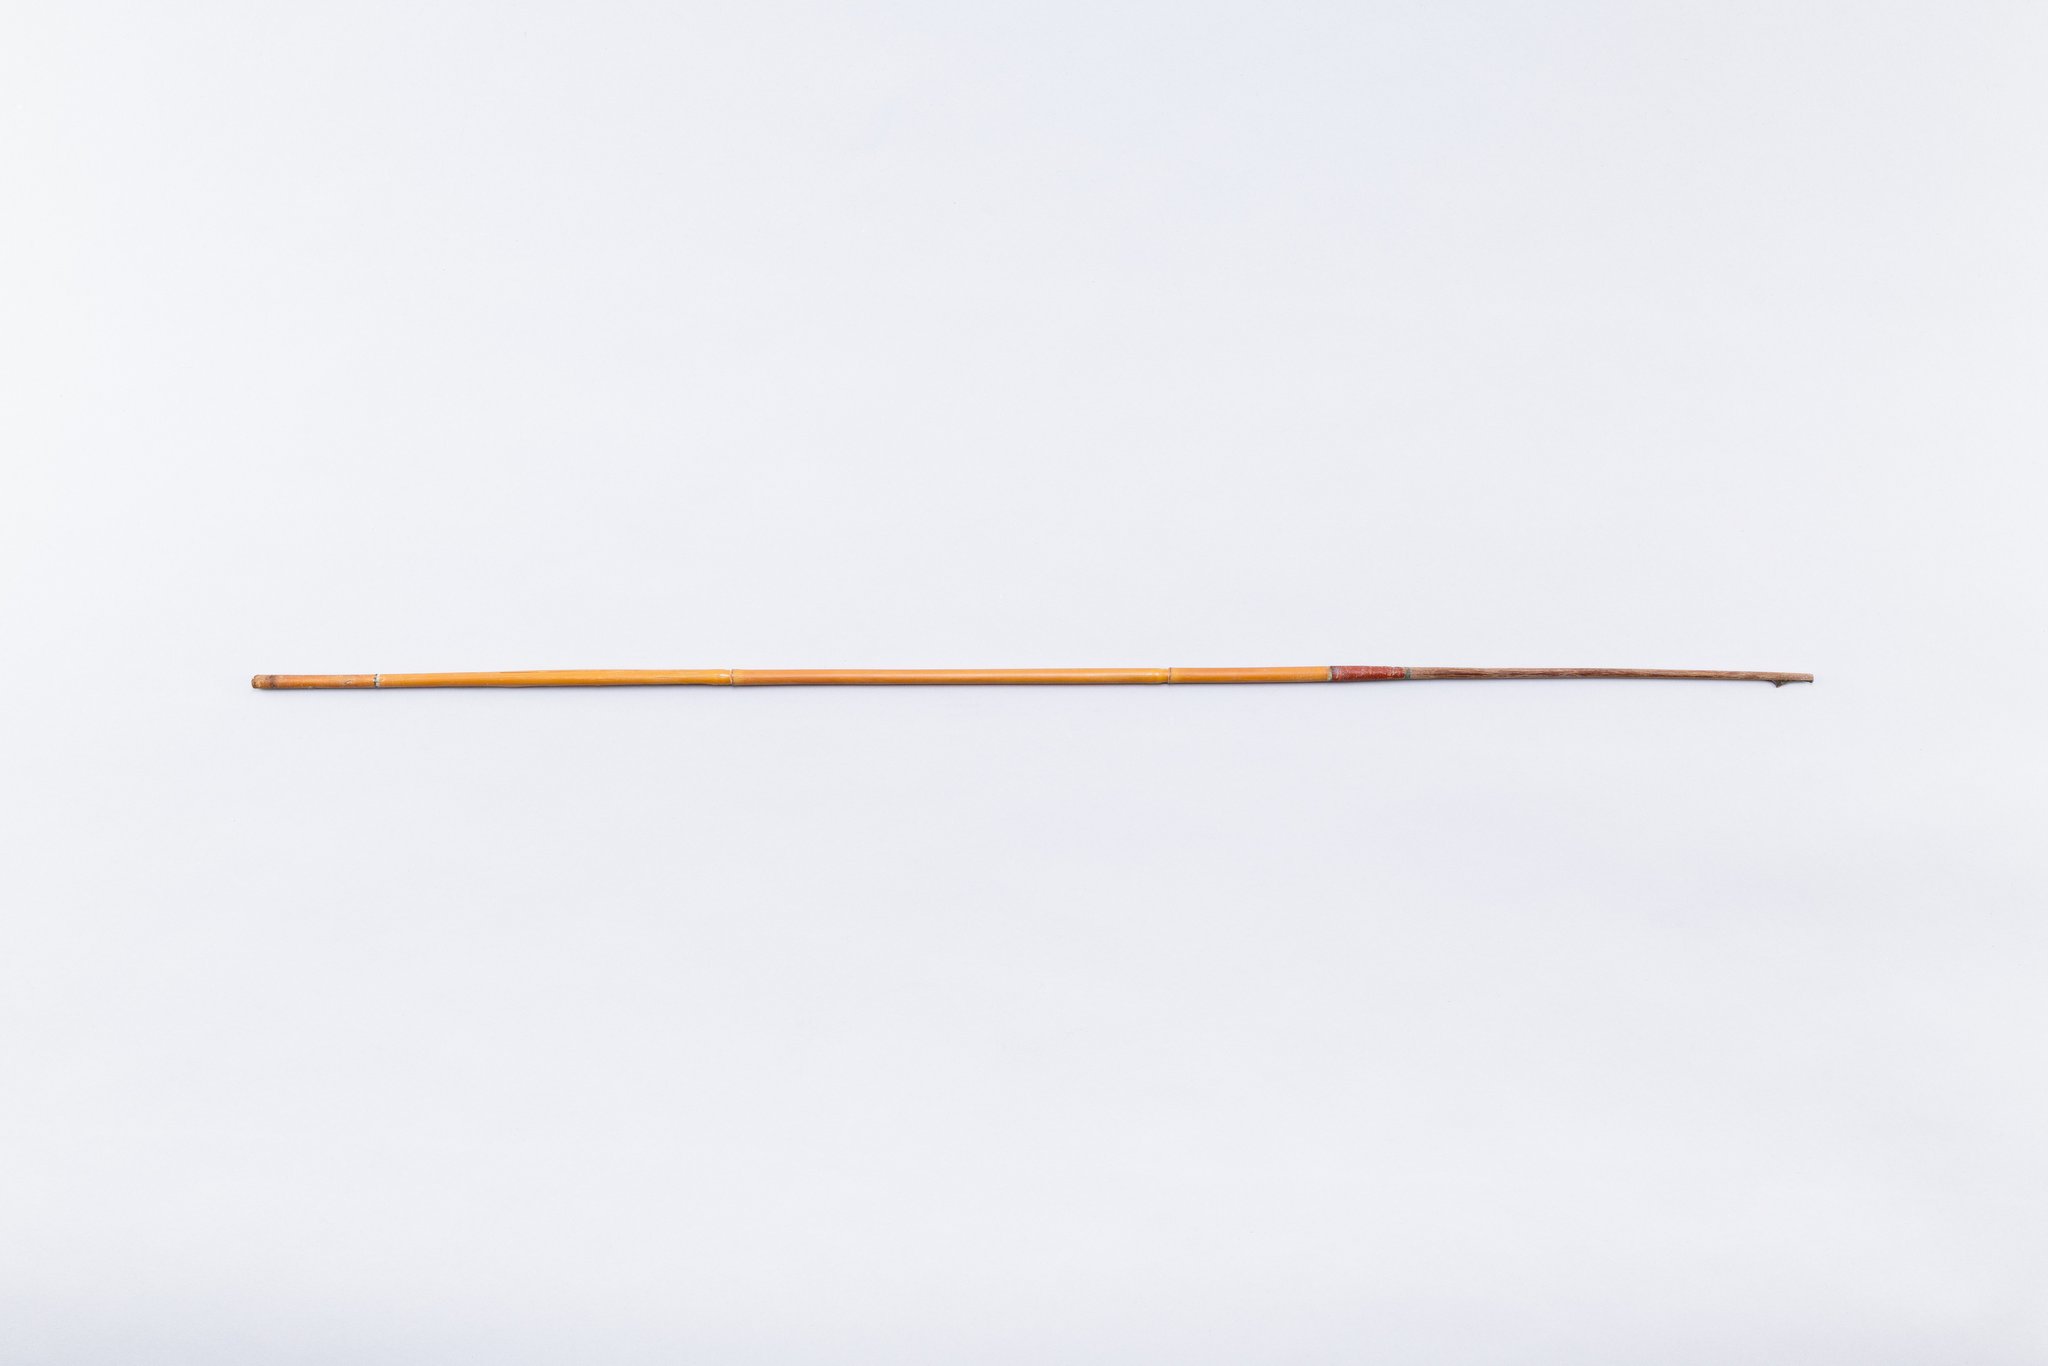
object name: arrow, arrowhead, adhesive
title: Arrow with a broken shaft and composite stone tip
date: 1479-1458 BCE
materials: quartz, wood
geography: egypt